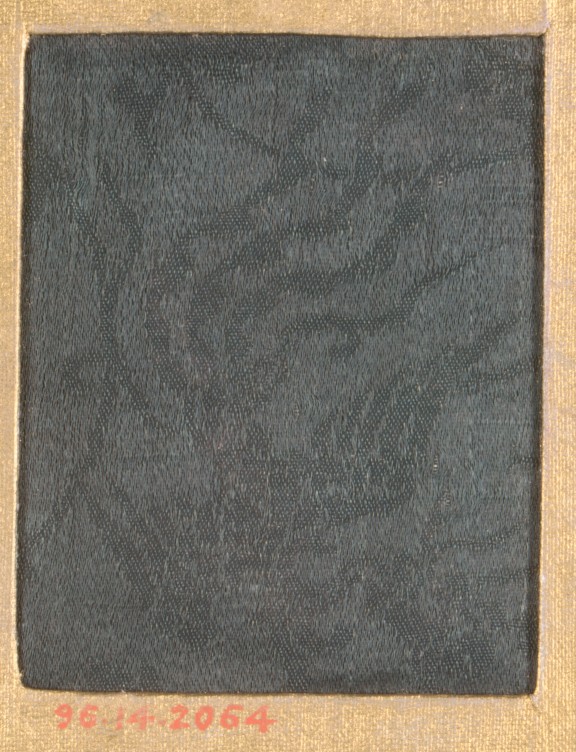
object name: piece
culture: japanese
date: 1701-1900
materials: silk